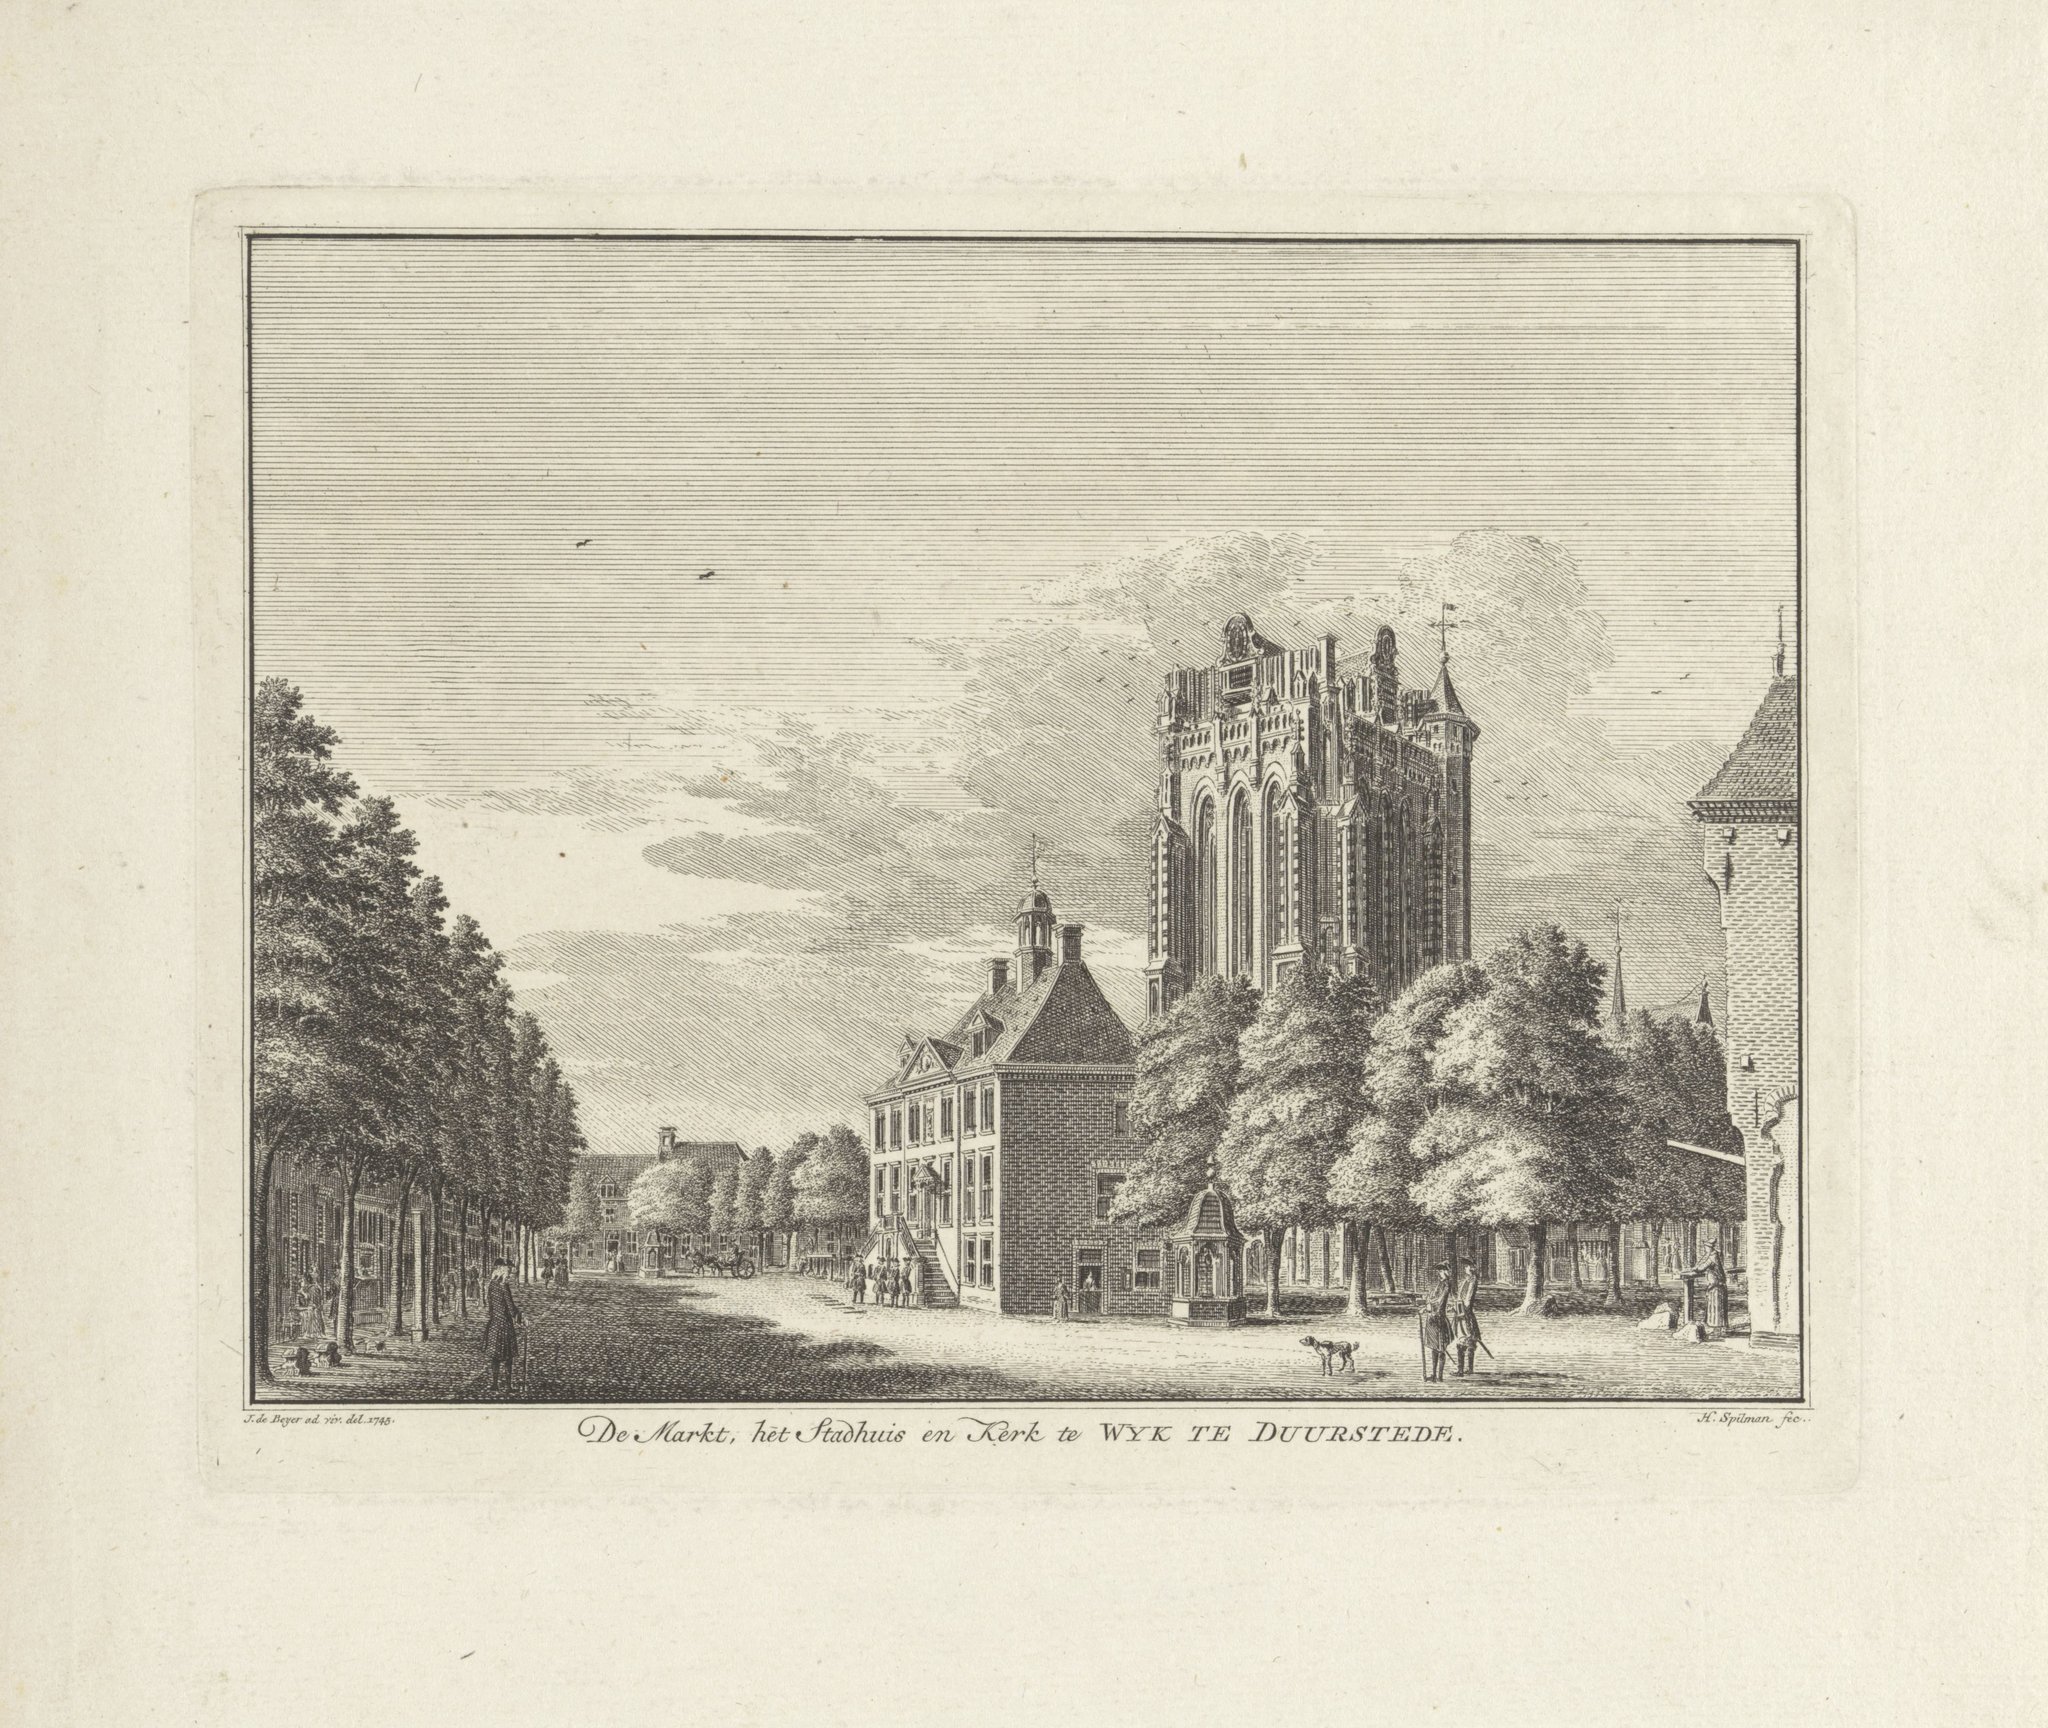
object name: print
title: De markt, het stadhuis en kerk te Wyk te Duurstede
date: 1745-1772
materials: paper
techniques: engraving, etching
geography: amsterdam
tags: townhall, public road in village (+ city(-scape) with figures, staffage), parts of church exterior and annexes: tower, wijk bij duurstede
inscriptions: collector's mark: Lugt 2760, collector's mark: Lugt 2228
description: Prent ook gebruikt in: Tegenwoordige staat der Vereenigde Nederlanden, twaalfde deel, vervolgende de beschryving van de provincie van Utrecht. Met landkaarten, en printverbeeldingen versierd / Hedendaagsche historie, of tegenwoordige staat van alle volkeren; XXII. deel (…). Amsterdam: weduwe Isaac Tirion, 1772, tussen p. 92 en p. 93.